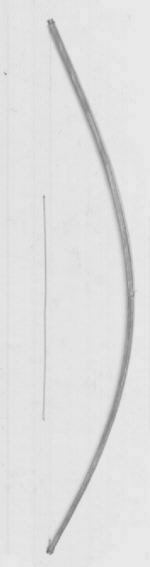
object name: samuius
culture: south african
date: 1867-1900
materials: metal, wood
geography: south africa